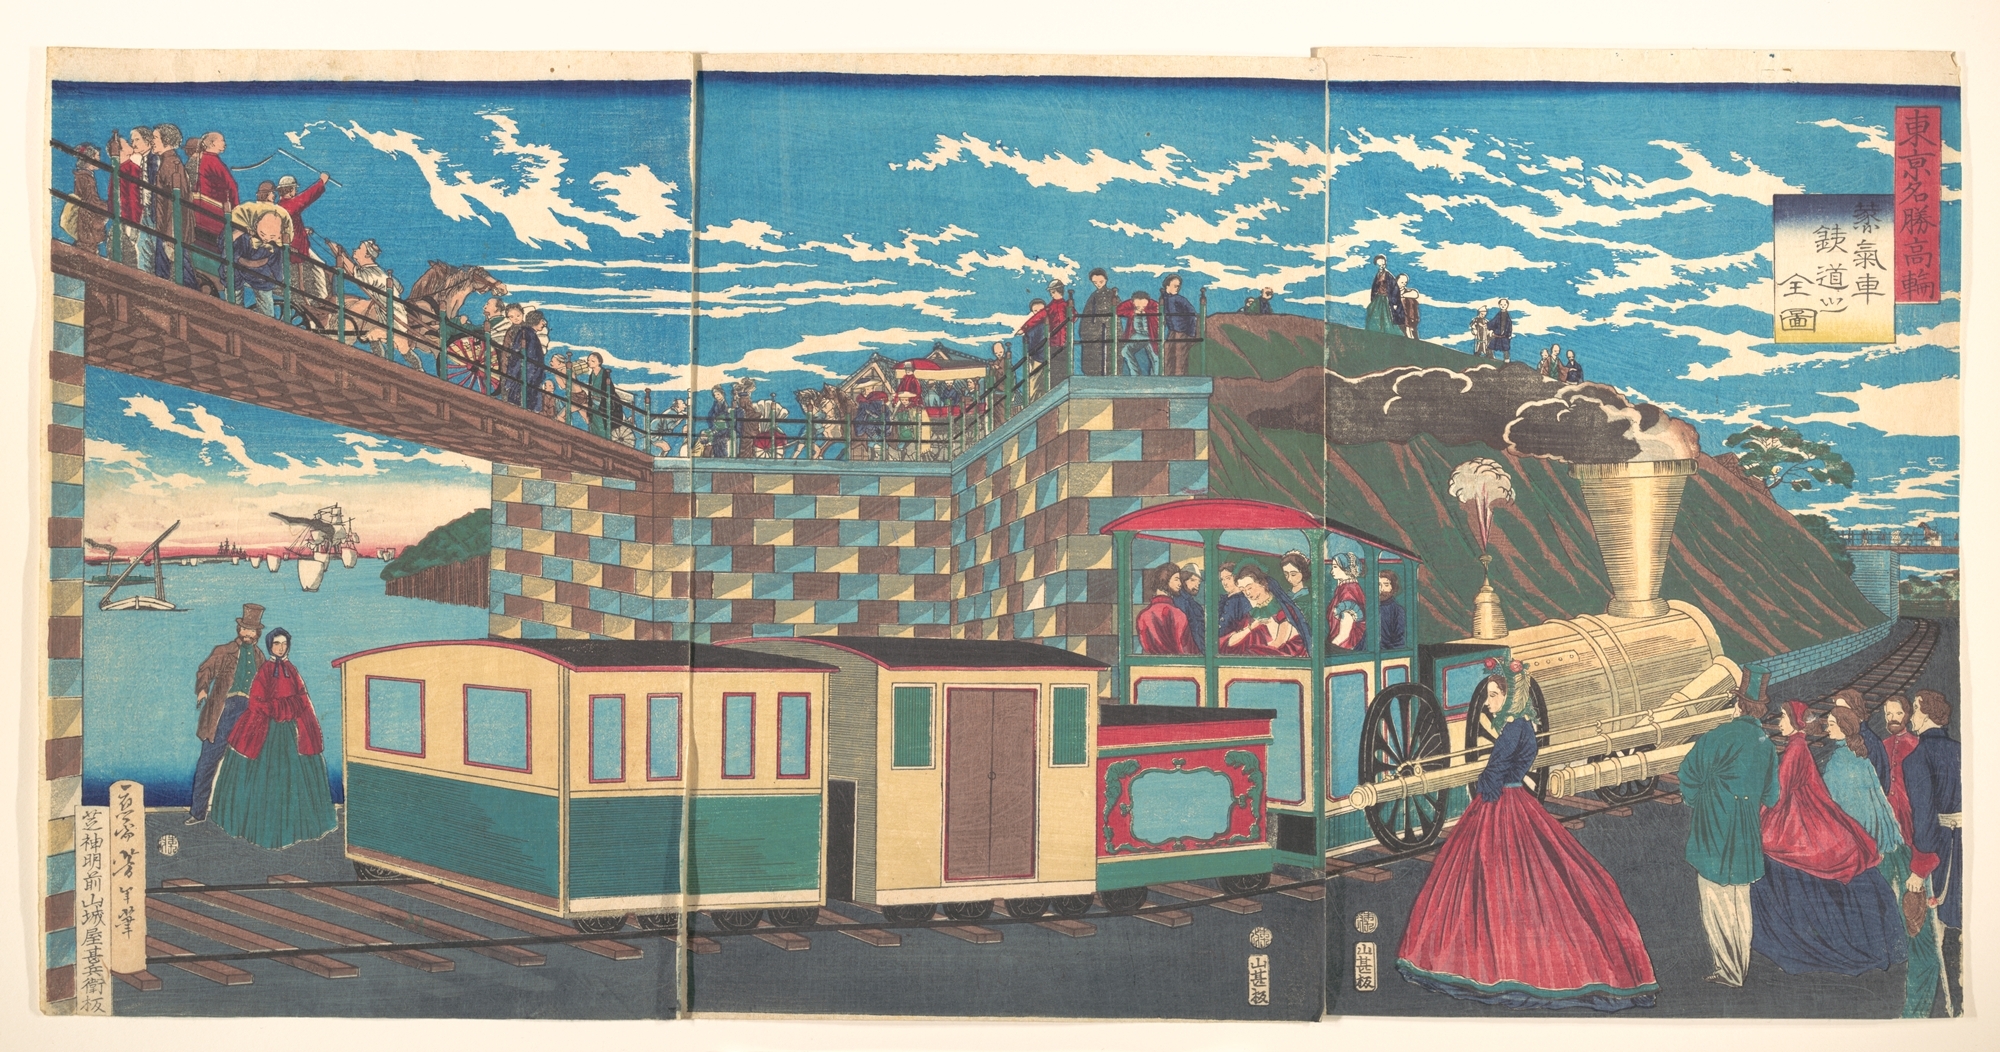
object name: print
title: Illustration of Steam Locomotive Tracks at Takanawa, from the series Famous Places in Tokyo (Tōkyō meishō Takanawa-jōki kikansha no zen zu)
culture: japanese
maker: tsukioka yoshitoshi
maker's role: artist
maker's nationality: japanese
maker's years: 1839-1892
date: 1872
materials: ink, paper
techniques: woodblock print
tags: bridges,men,women,trains